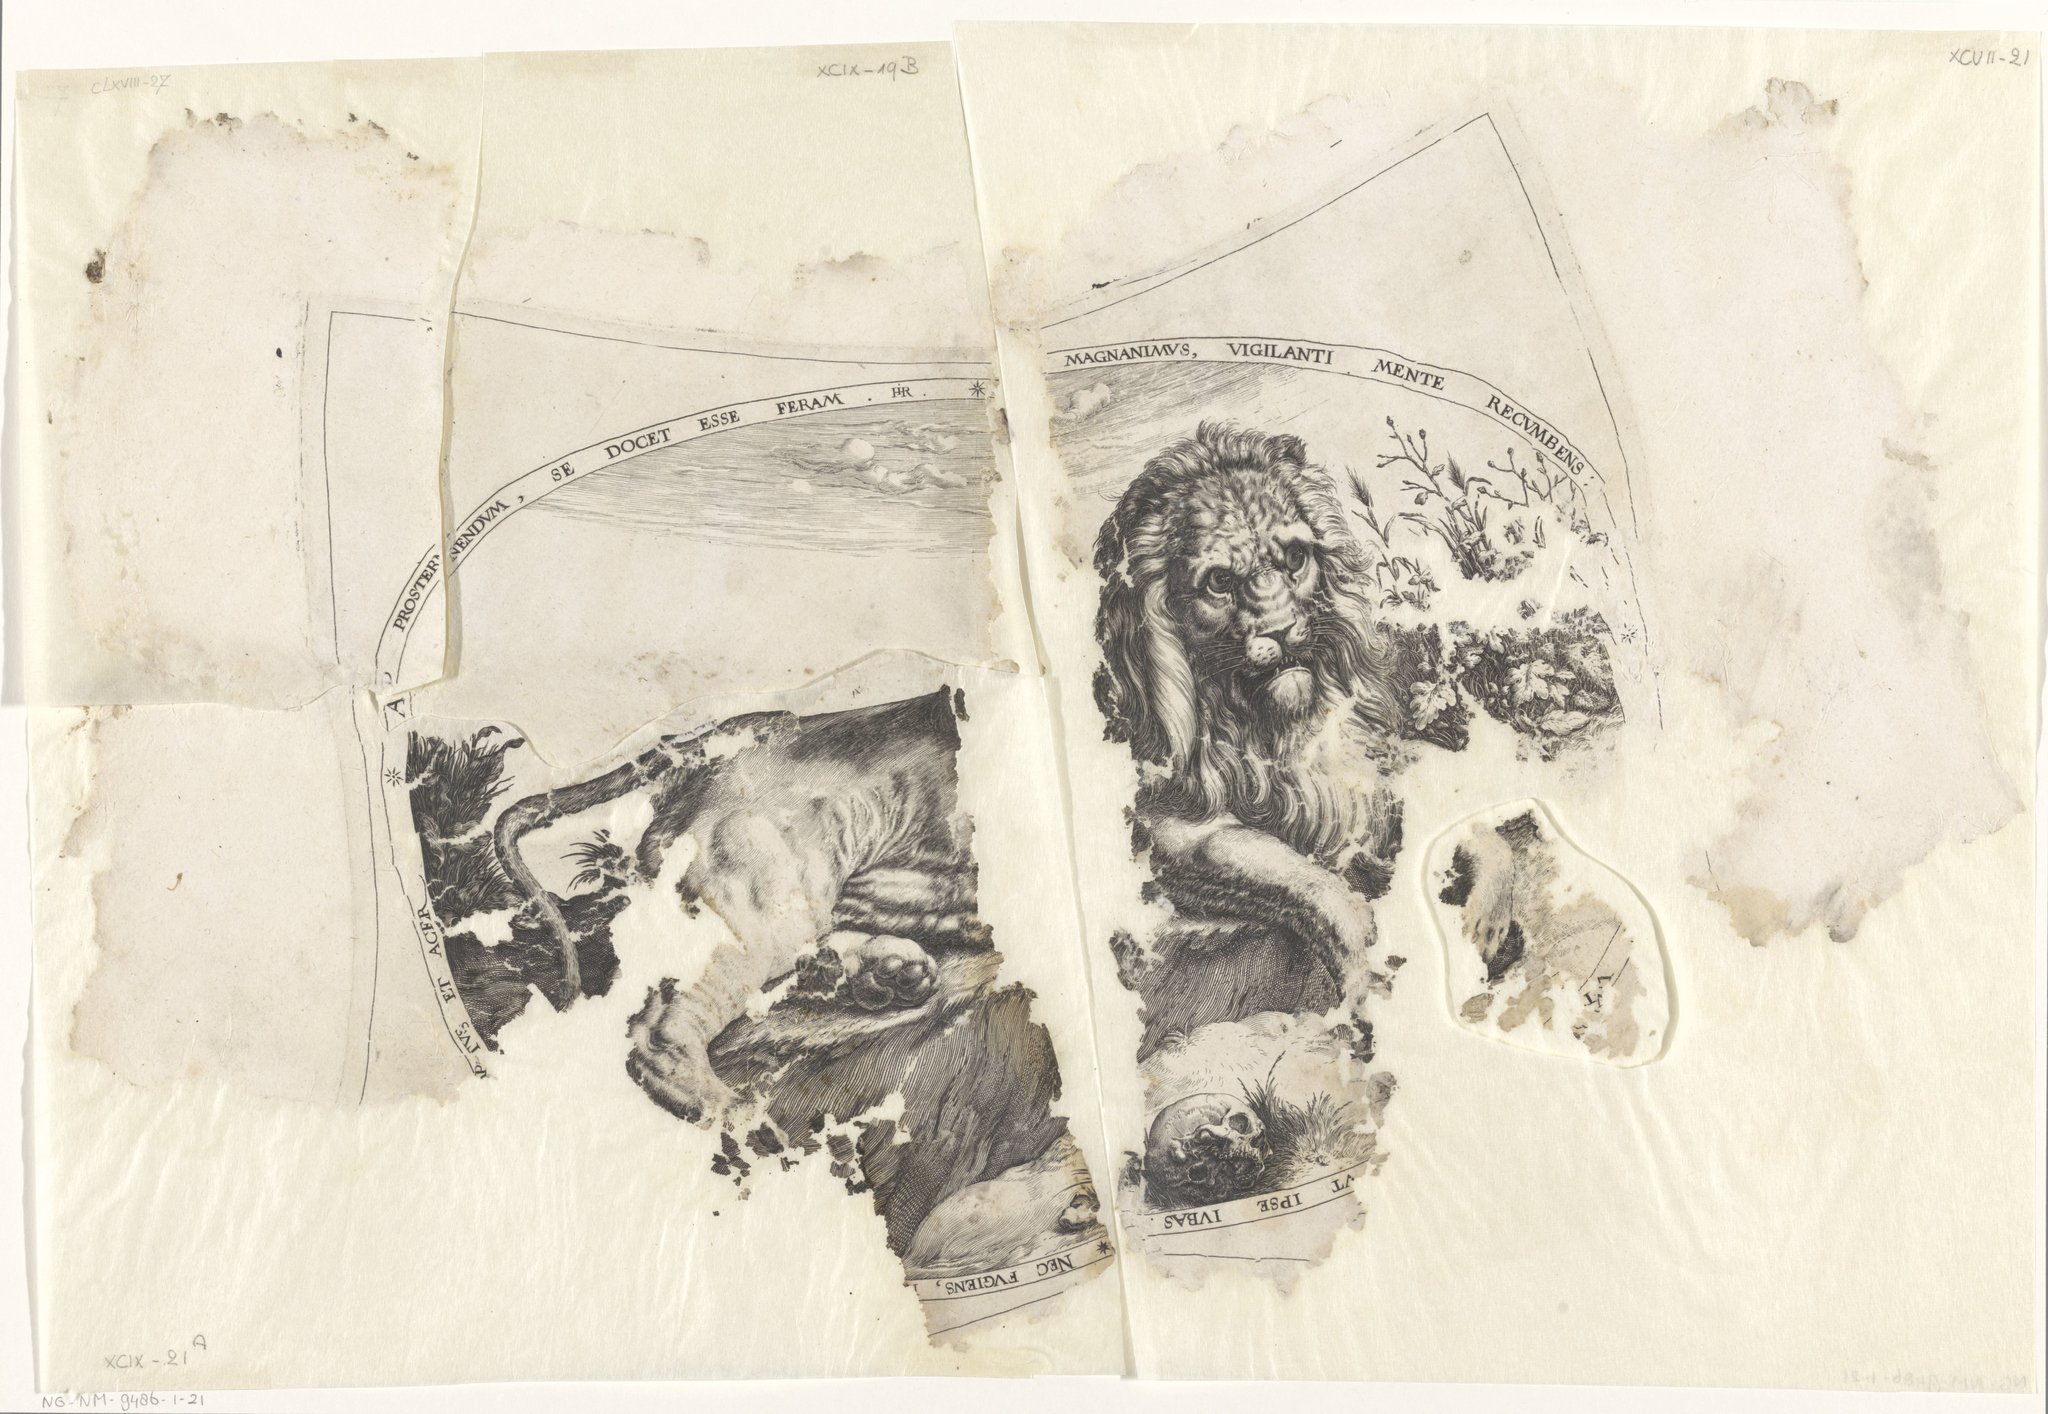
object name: print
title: Leeuw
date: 1580-1596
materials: paper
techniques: engraving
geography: northern netherlands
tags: beasts of prey, predatory animals: lion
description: De prenten in de Nova Zembla collectie zijn tijdens een expeditie van Willem Barendsz en Jacob van Heemskerk in 1596-1597 noodgedwongen in het winterkamp, het ‘Behouden Huis’, op het eiland achtergelaten. De prenten waren in één of meerdere stapels als handelswaar meegenomen vanuit Amsterdam. Bijna drie eeuwen later, in 1871, keerde de Noor Elling Carlsen terug naar Nova Zembla en vond daar de restanten van het ‘Behouden Huis, inclusief een groot deel van de inventaris. Een deel van de prenten, in de vorm van aaneengekoekte kluiten, werd toen ook teruggevonden. De papierkluiten waren soms op meerdere plekken gebroken. Tussen 1975-1979 zijn de prenten van elkaar gescheiden. Dit leverde in totaal ca. 1000 fragmenten van ca. 400 afdrukken van ca. 150 verschillende prenten op. Voor zover mogelijk zijn de fragmenten samengevoegd en zijn de prenten gereconstrueerd.